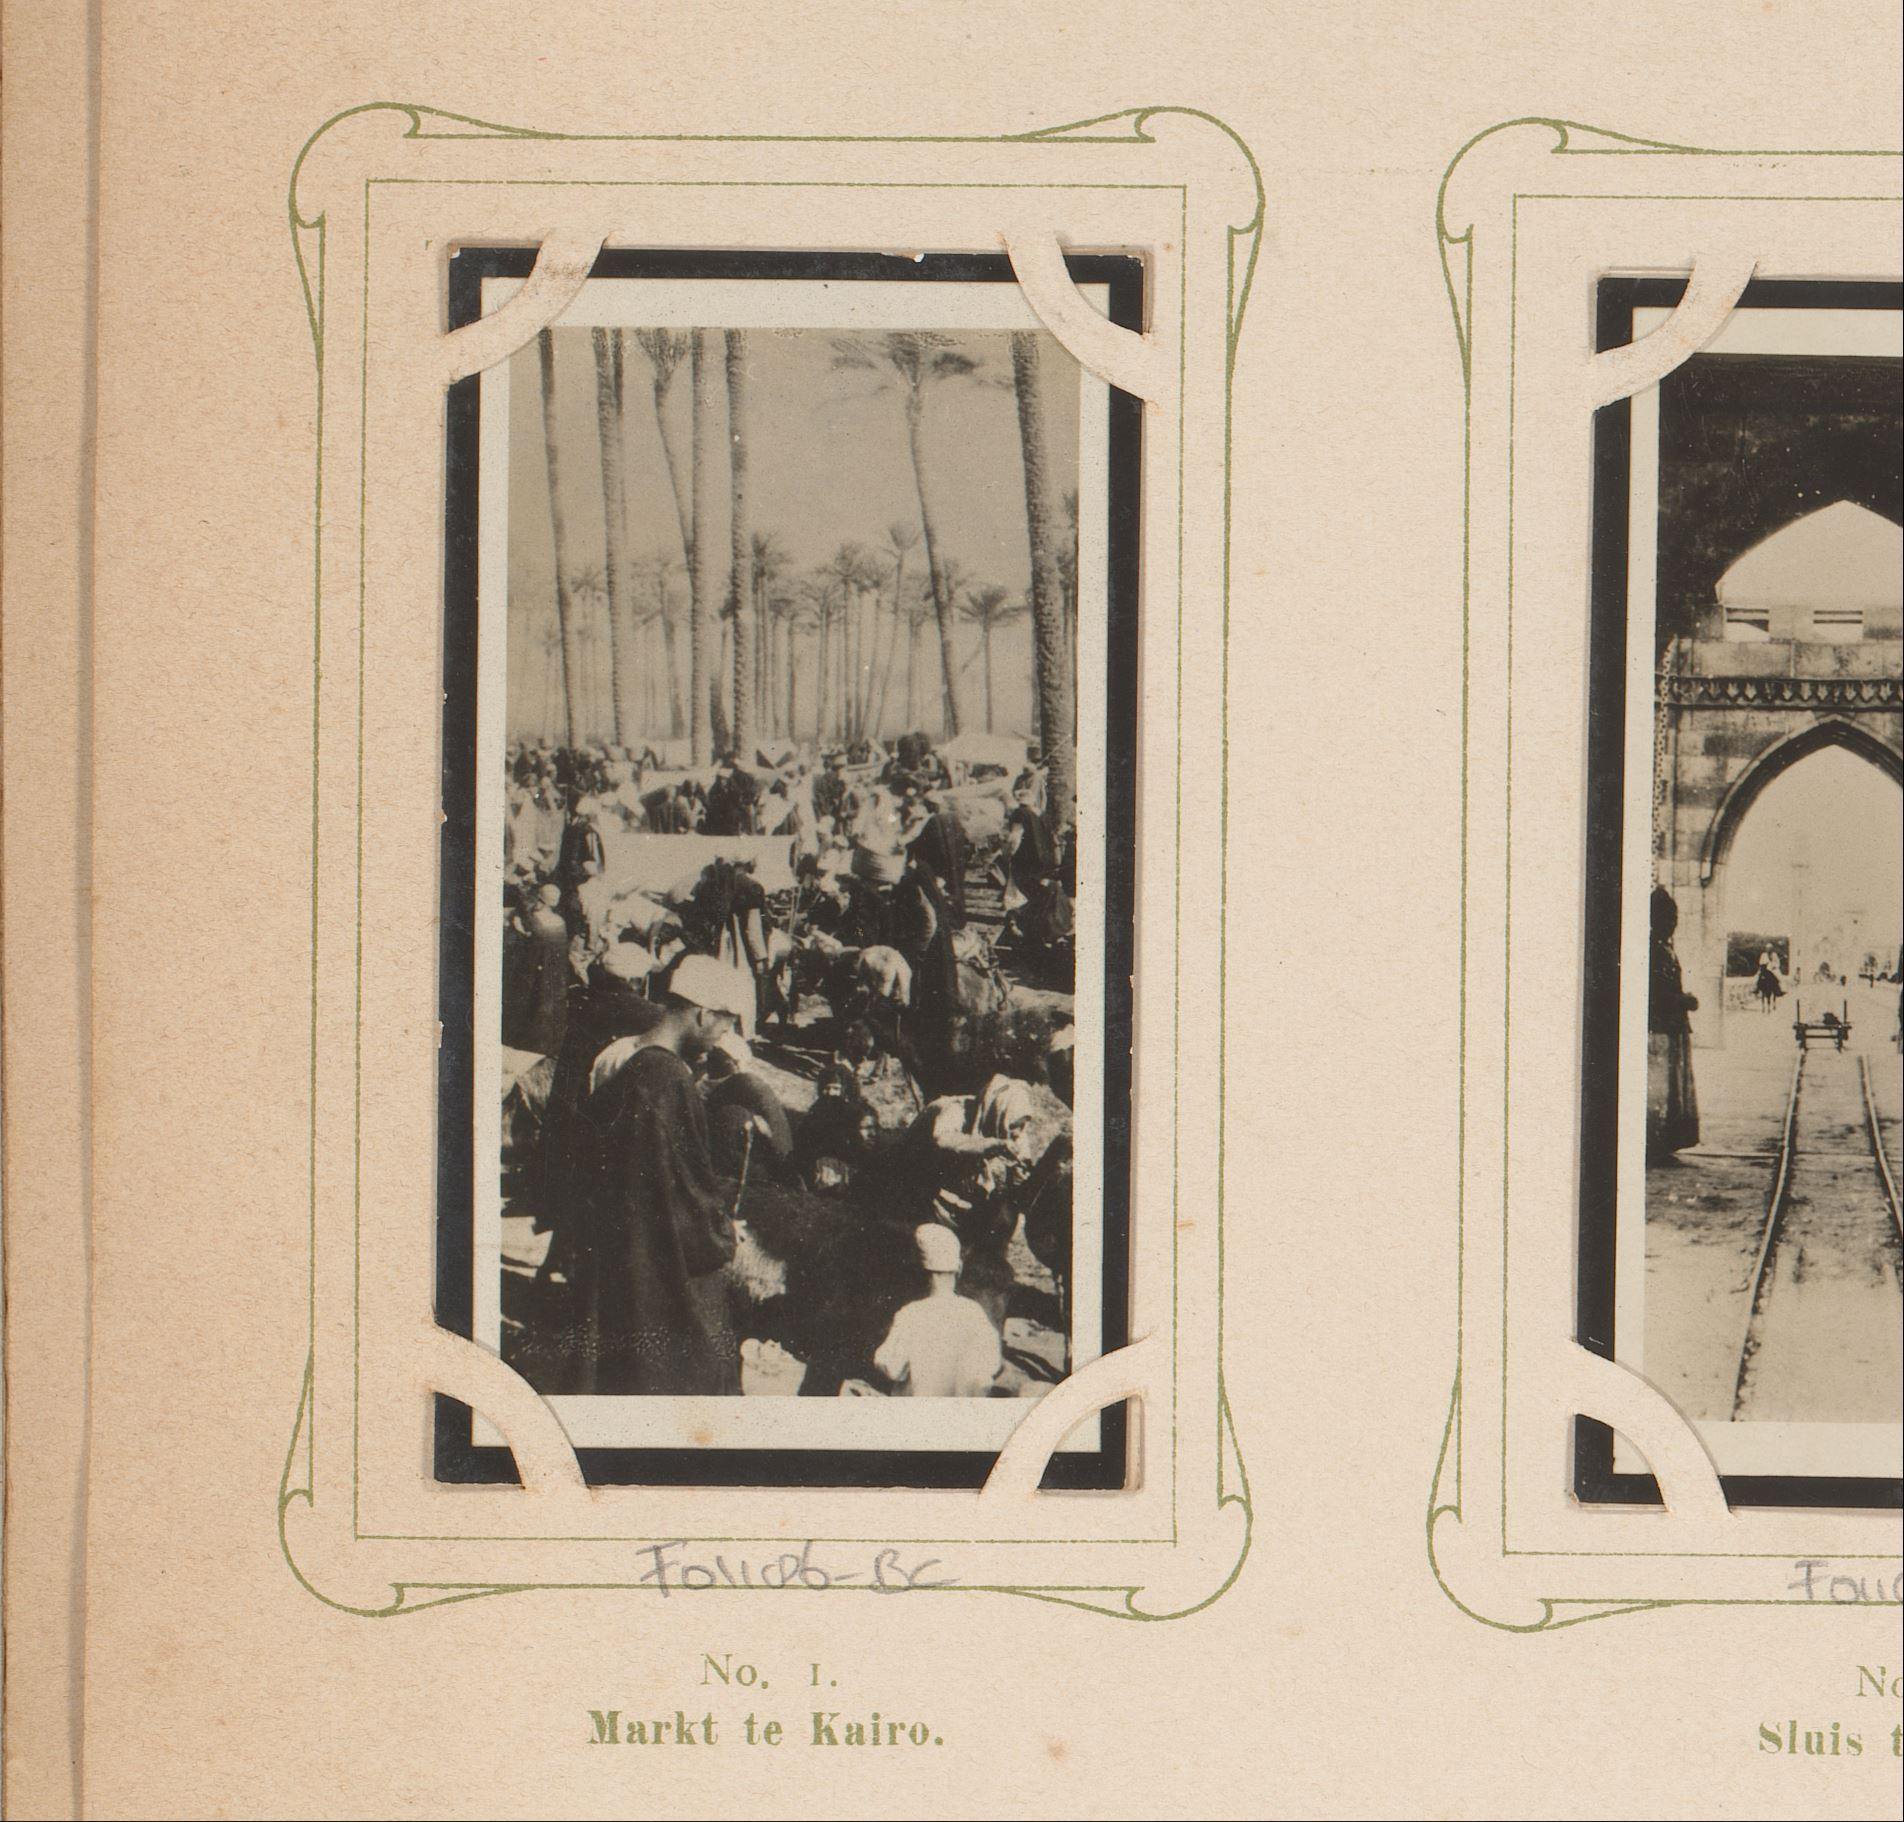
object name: album leaf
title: Gezicht op een markt te Caïro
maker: Anonymous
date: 1904-1905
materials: photographic support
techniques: gelatin silver print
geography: cairo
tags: market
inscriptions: inscription: ‘No. 1./ Markt de Kairo’